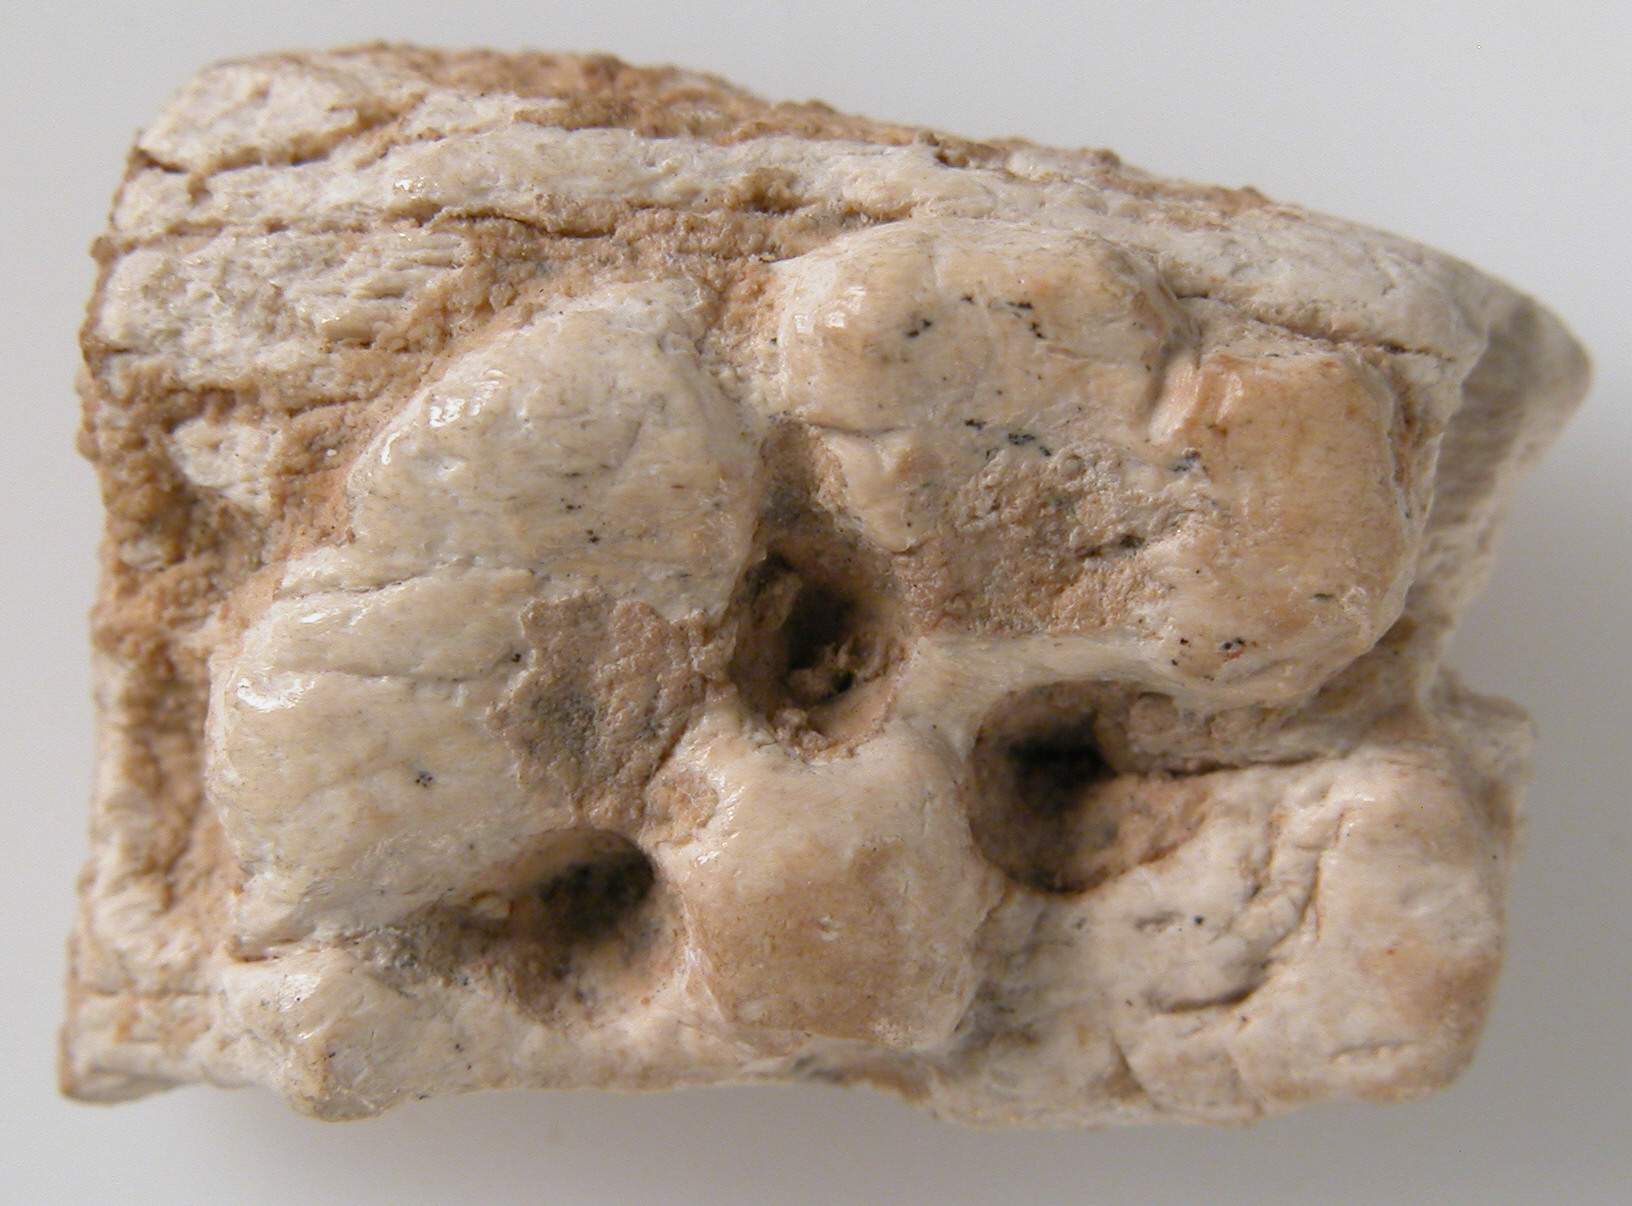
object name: fragment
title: Relief Fragment with Part of a Rosette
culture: coptic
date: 501-700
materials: ivory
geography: egypt